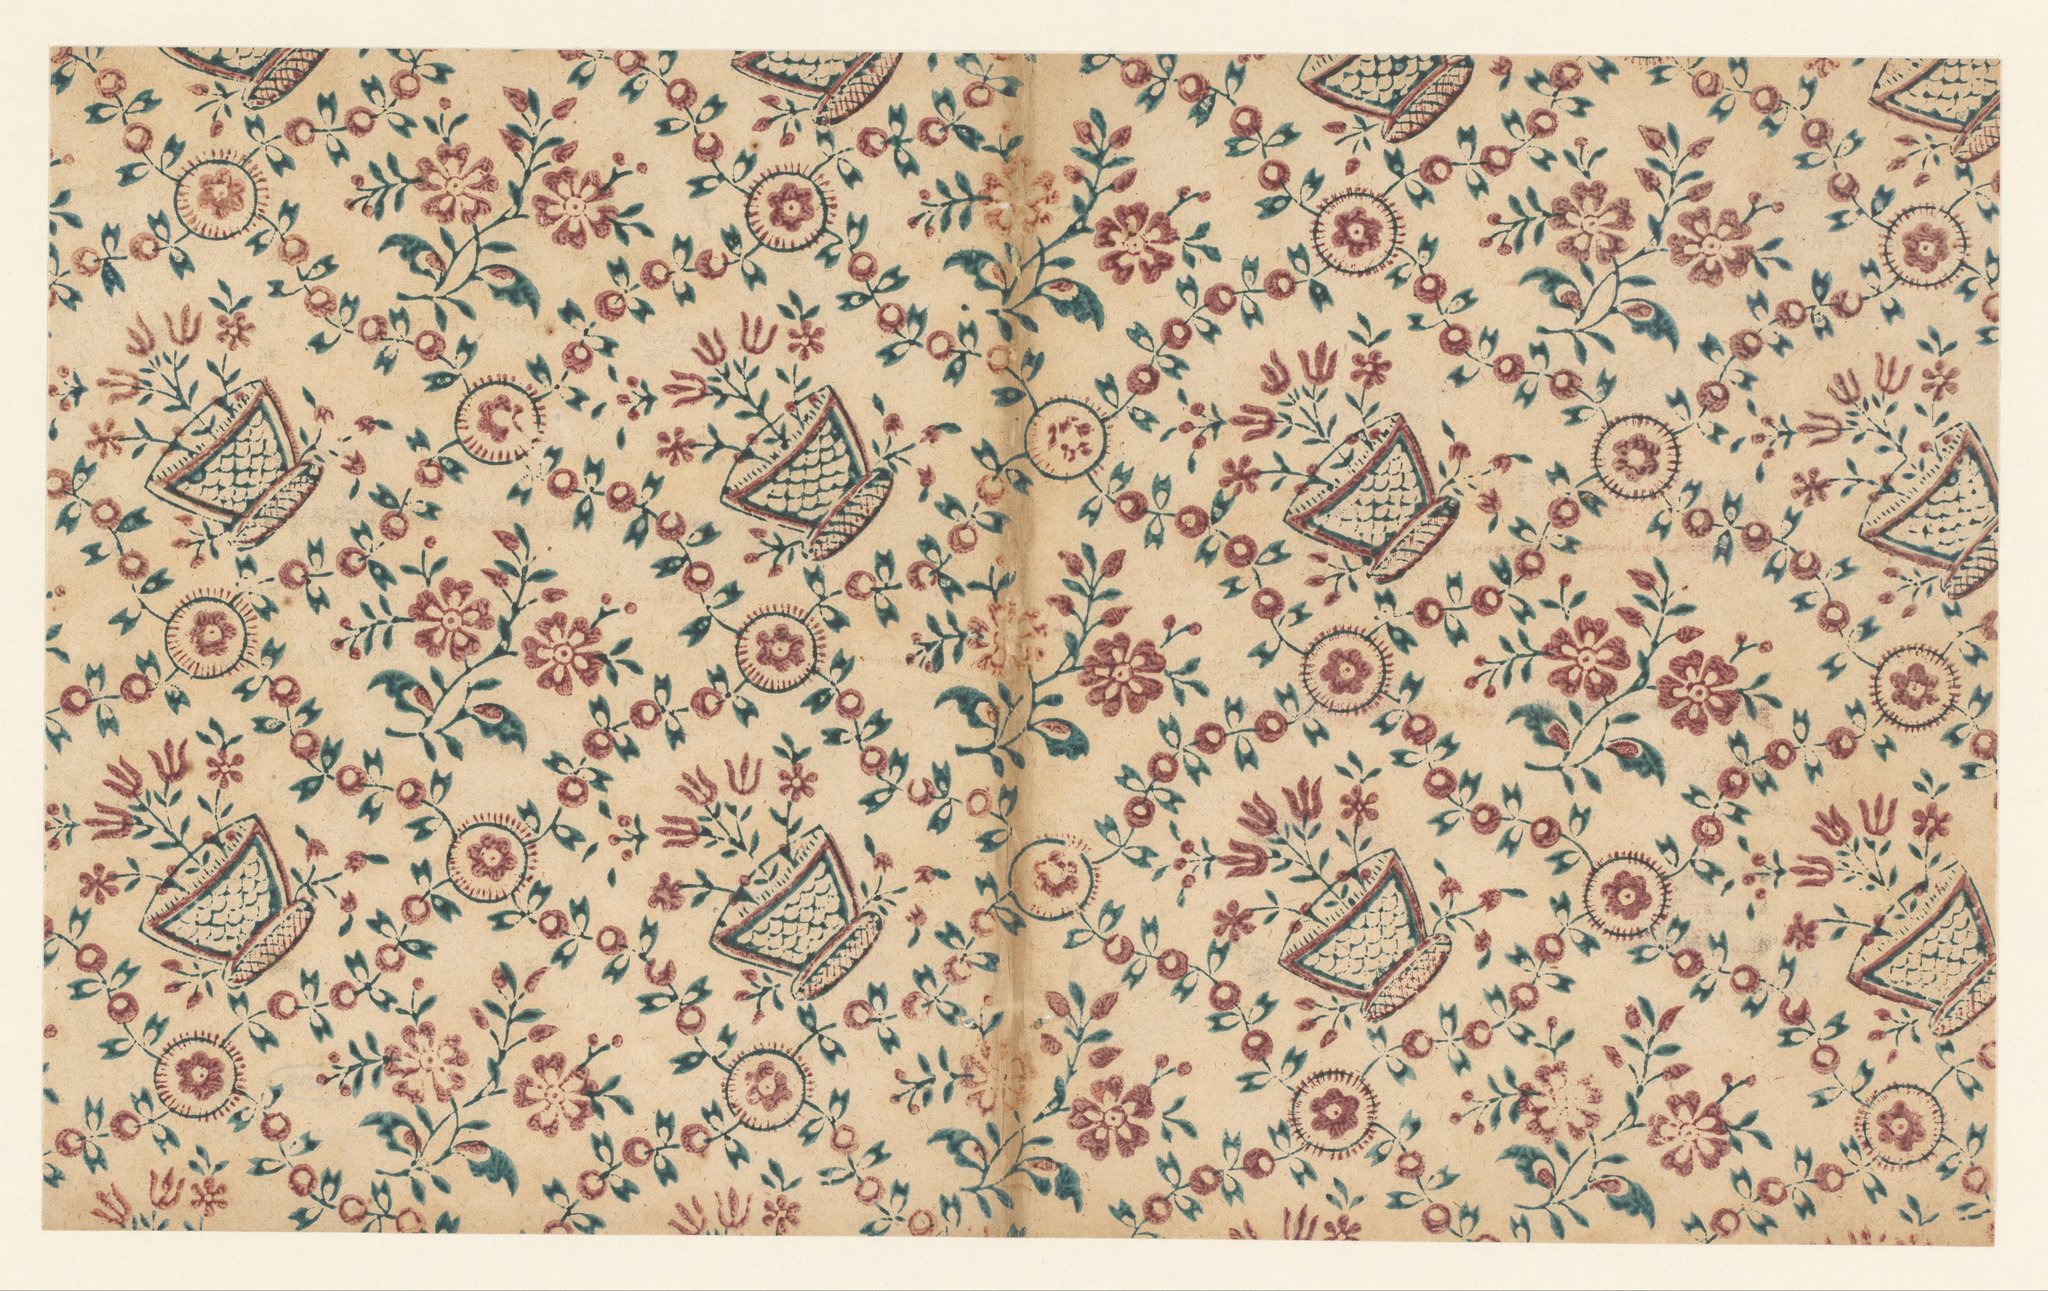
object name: wrapper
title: Blad met patroon van bloempotten tussen bladranken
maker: Anonymous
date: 1700-1850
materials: paper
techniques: printing block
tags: ornament derived from plant forms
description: Blad met patroon van bloempotten tussen bladranken met bloemen. Gebruikt als omslag.